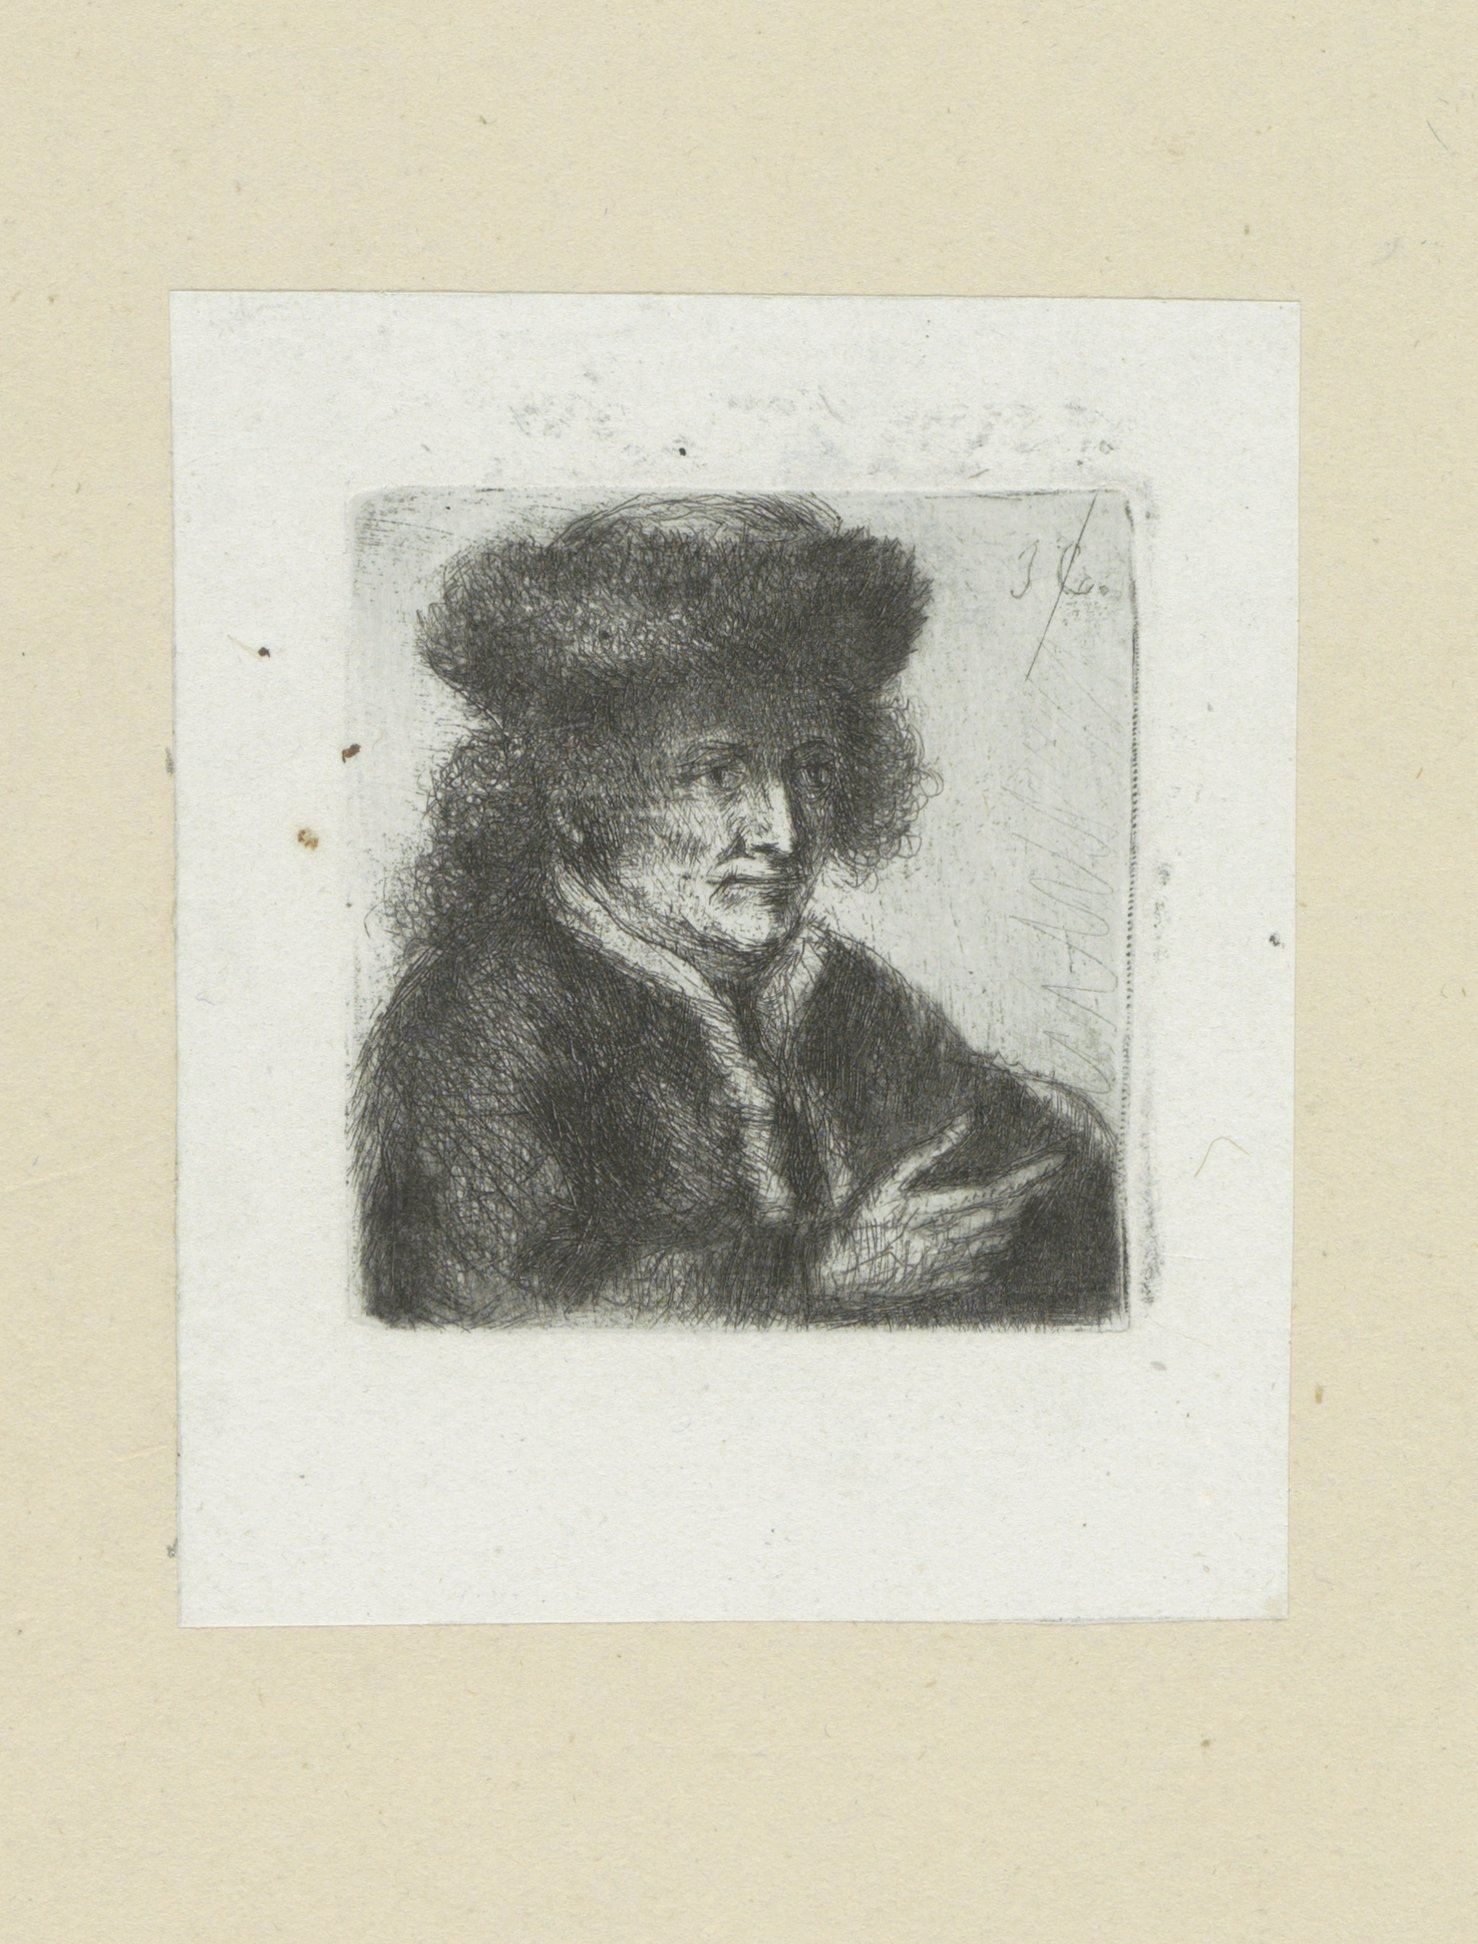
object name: album leaf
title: Volwassen man met bontmuts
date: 1802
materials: paper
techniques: drypoint, etching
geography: london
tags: head-gear: cap (+ men's clothes), morphology of human expression (+ adult male (human being))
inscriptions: collector's mark: ‘RIJKS / MUSM’, collector's mark: ‘B’